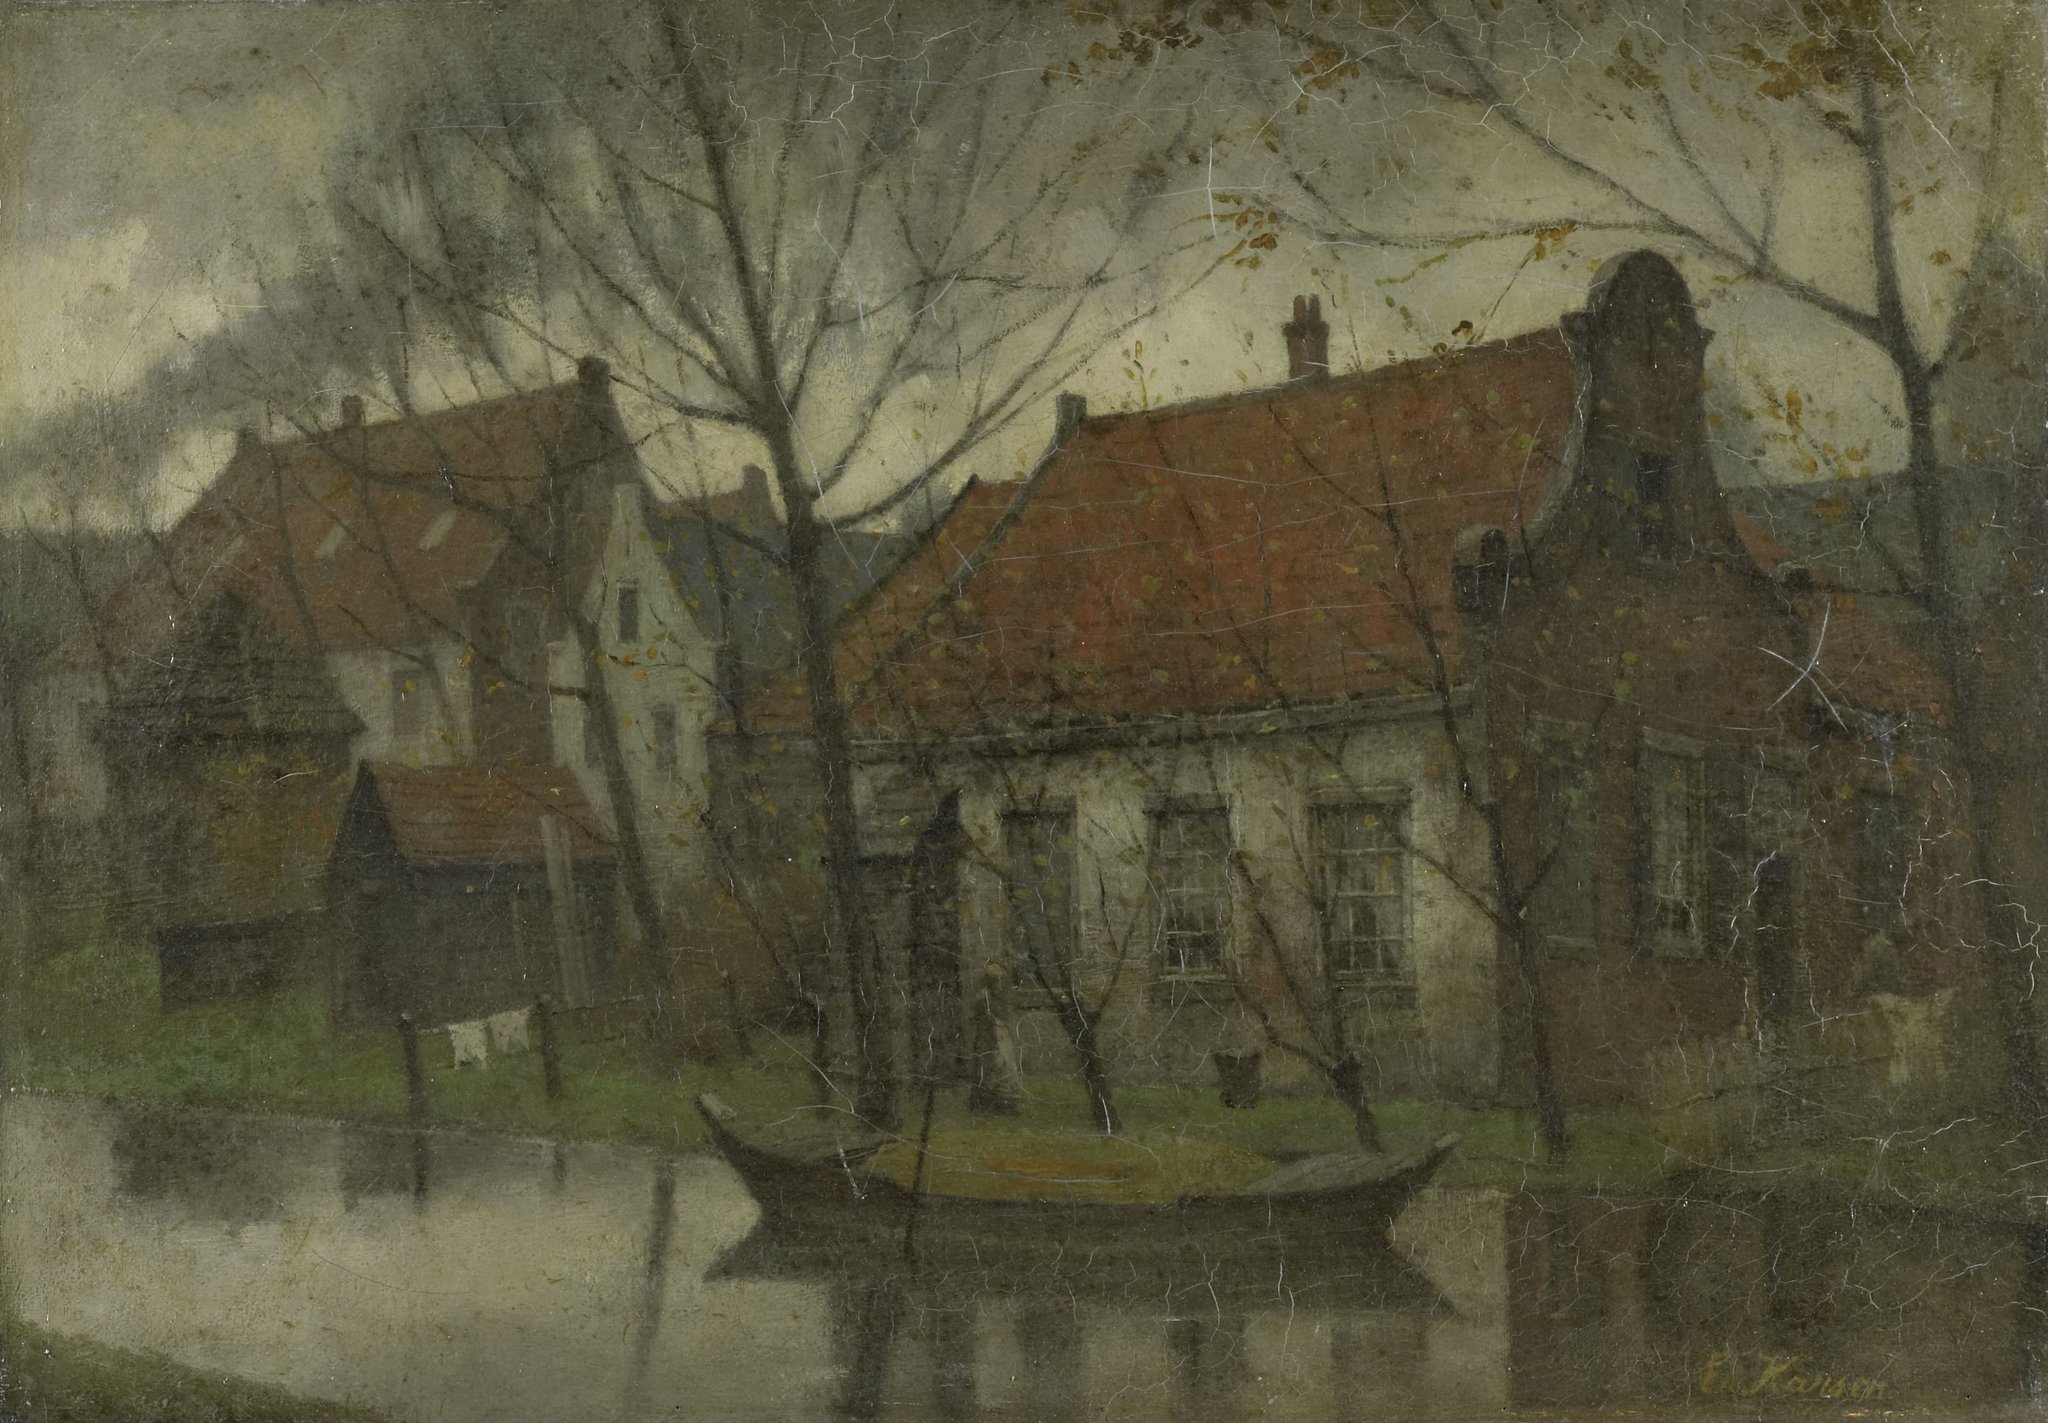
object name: painting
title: View in a Village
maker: eduard karsen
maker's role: draughtsman, painter, print maker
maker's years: 1860-1941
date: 1885-1900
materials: canvas, oil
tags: canals, waters (in village)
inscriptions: signature: ‘Ed. Karsen’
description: Dorpsgezicht. Gezicht op enkele huizen gelegen aan een vaart. Een platte schuit ligt bij een huis aangemeerd, rechts hangt een vrouw wasgoed over een schutting.